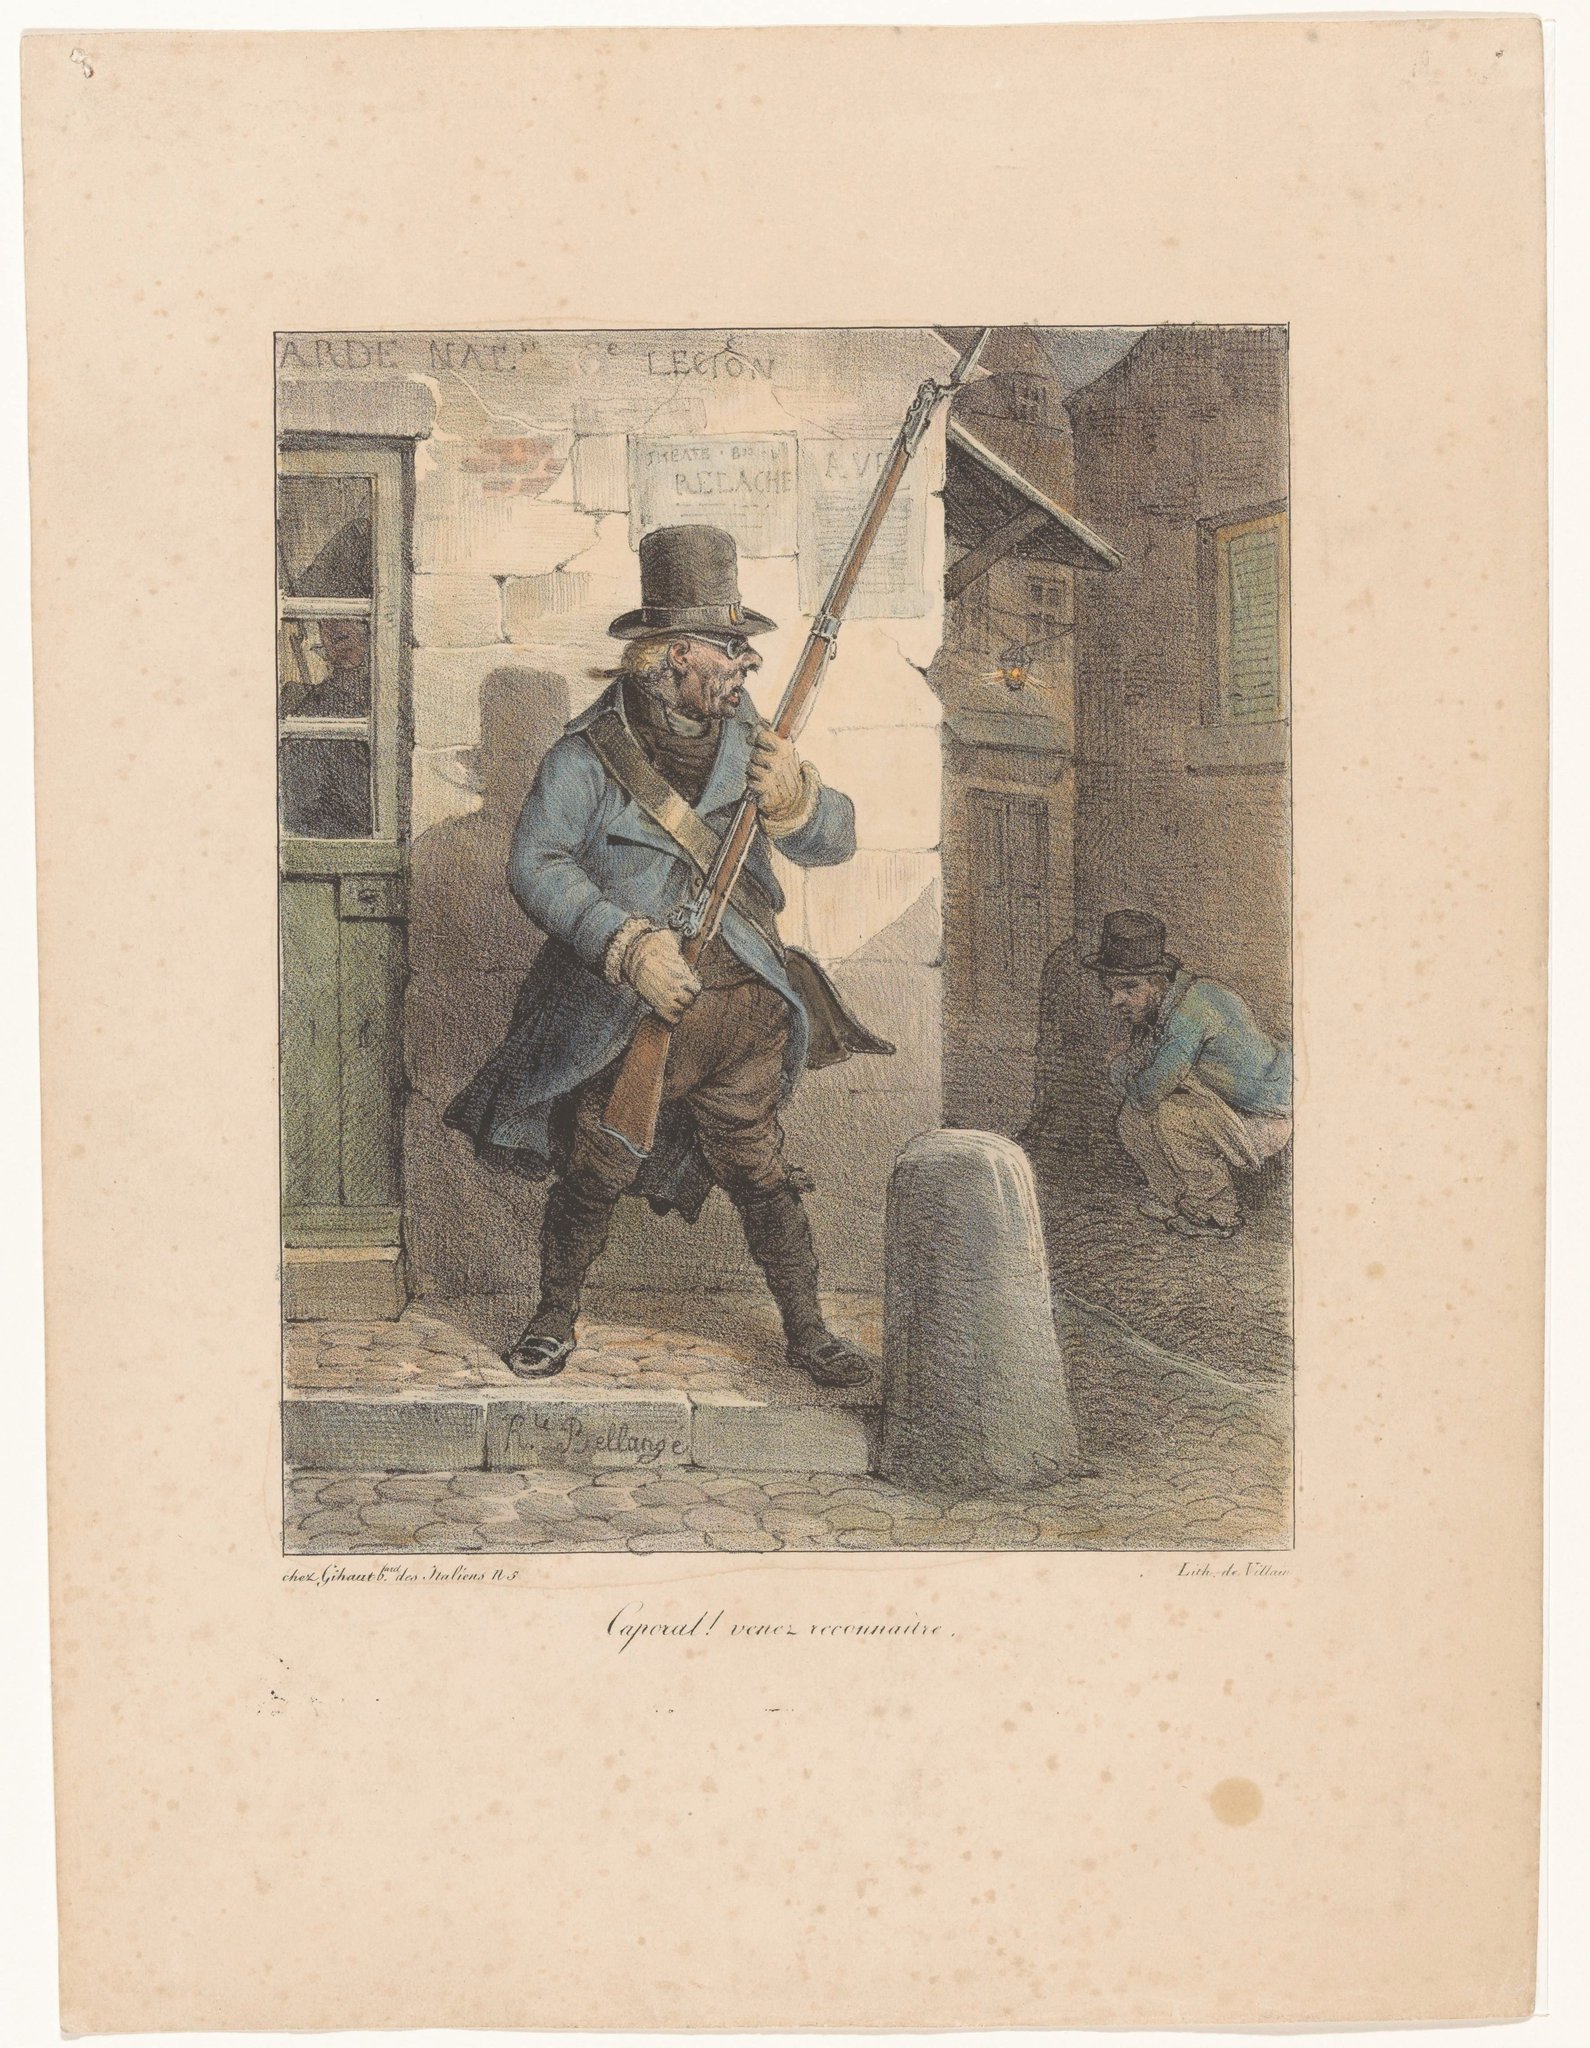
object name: print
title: Caporal! Venez reconnaître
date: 1823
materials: paper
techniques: hand coloring, lithograph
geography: paris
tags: military service, private soldier (+ weapons)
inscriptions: collector's mark: Lugt 2228a